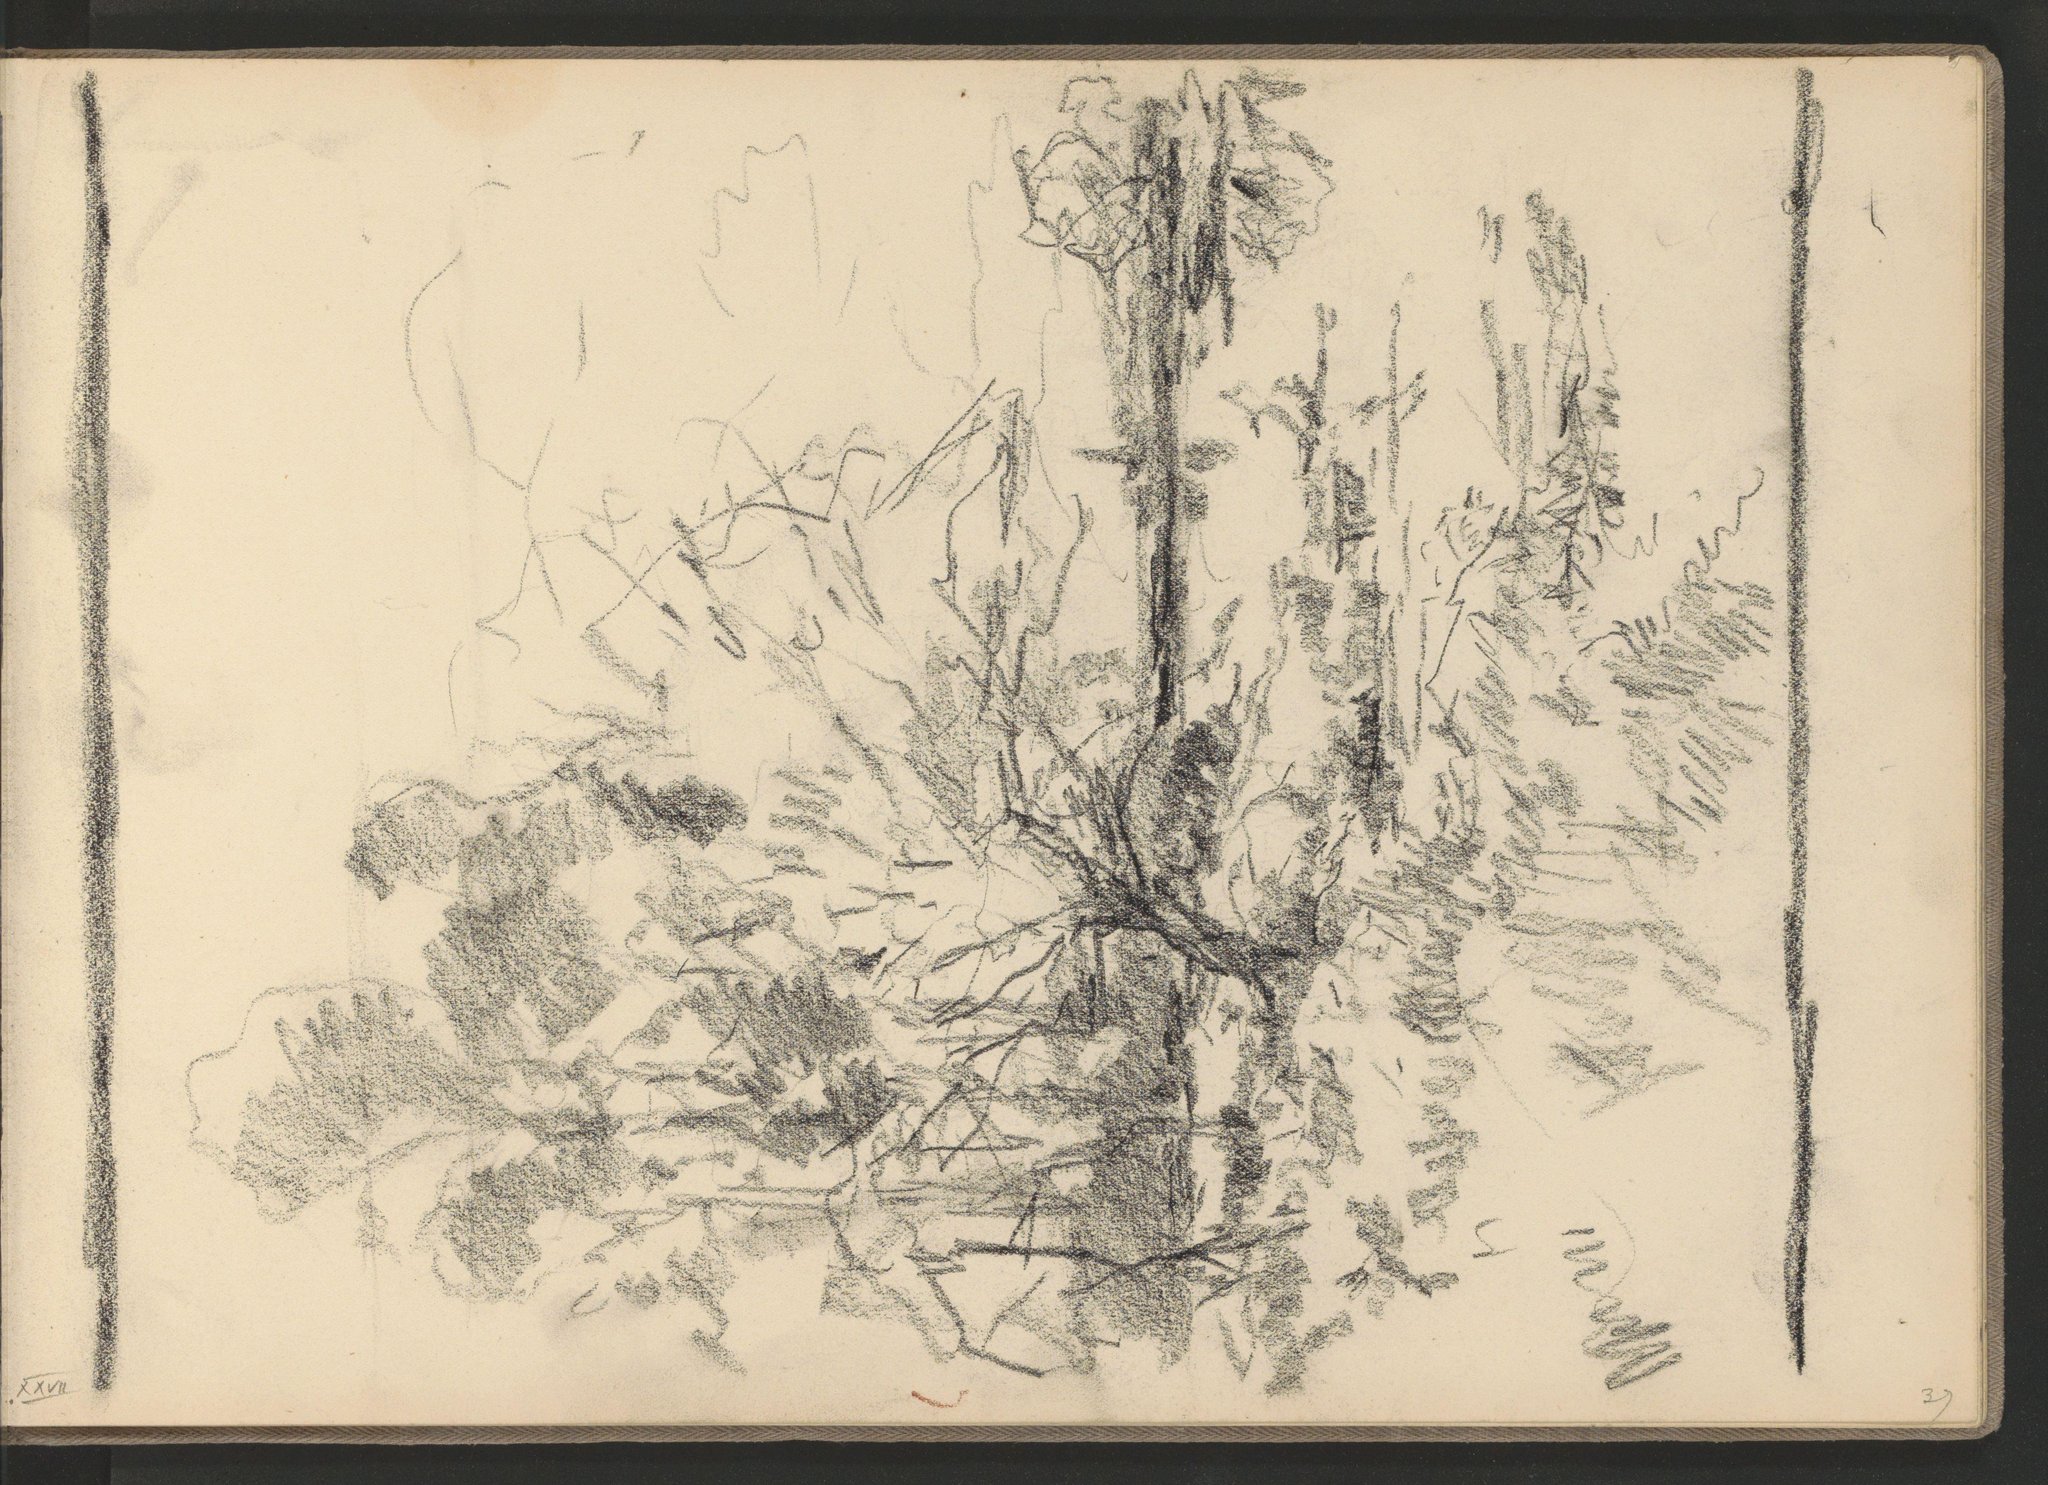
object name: sketchbook leaf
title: Landschap met bomen aan een waterkant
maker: egbert rubertus derk schaap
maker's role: draughtsman, painter, print maker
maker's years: 1862-1939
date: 1891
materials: chalk, paper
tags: trees, landscapes with waters, waterscapes, seascapes (in the temperate zone)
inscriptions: number: ‘XXVII’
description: Op de achtergrond het silhouet van een dorp. Pagina 37 uit een schetsboek met 64 pagina's.